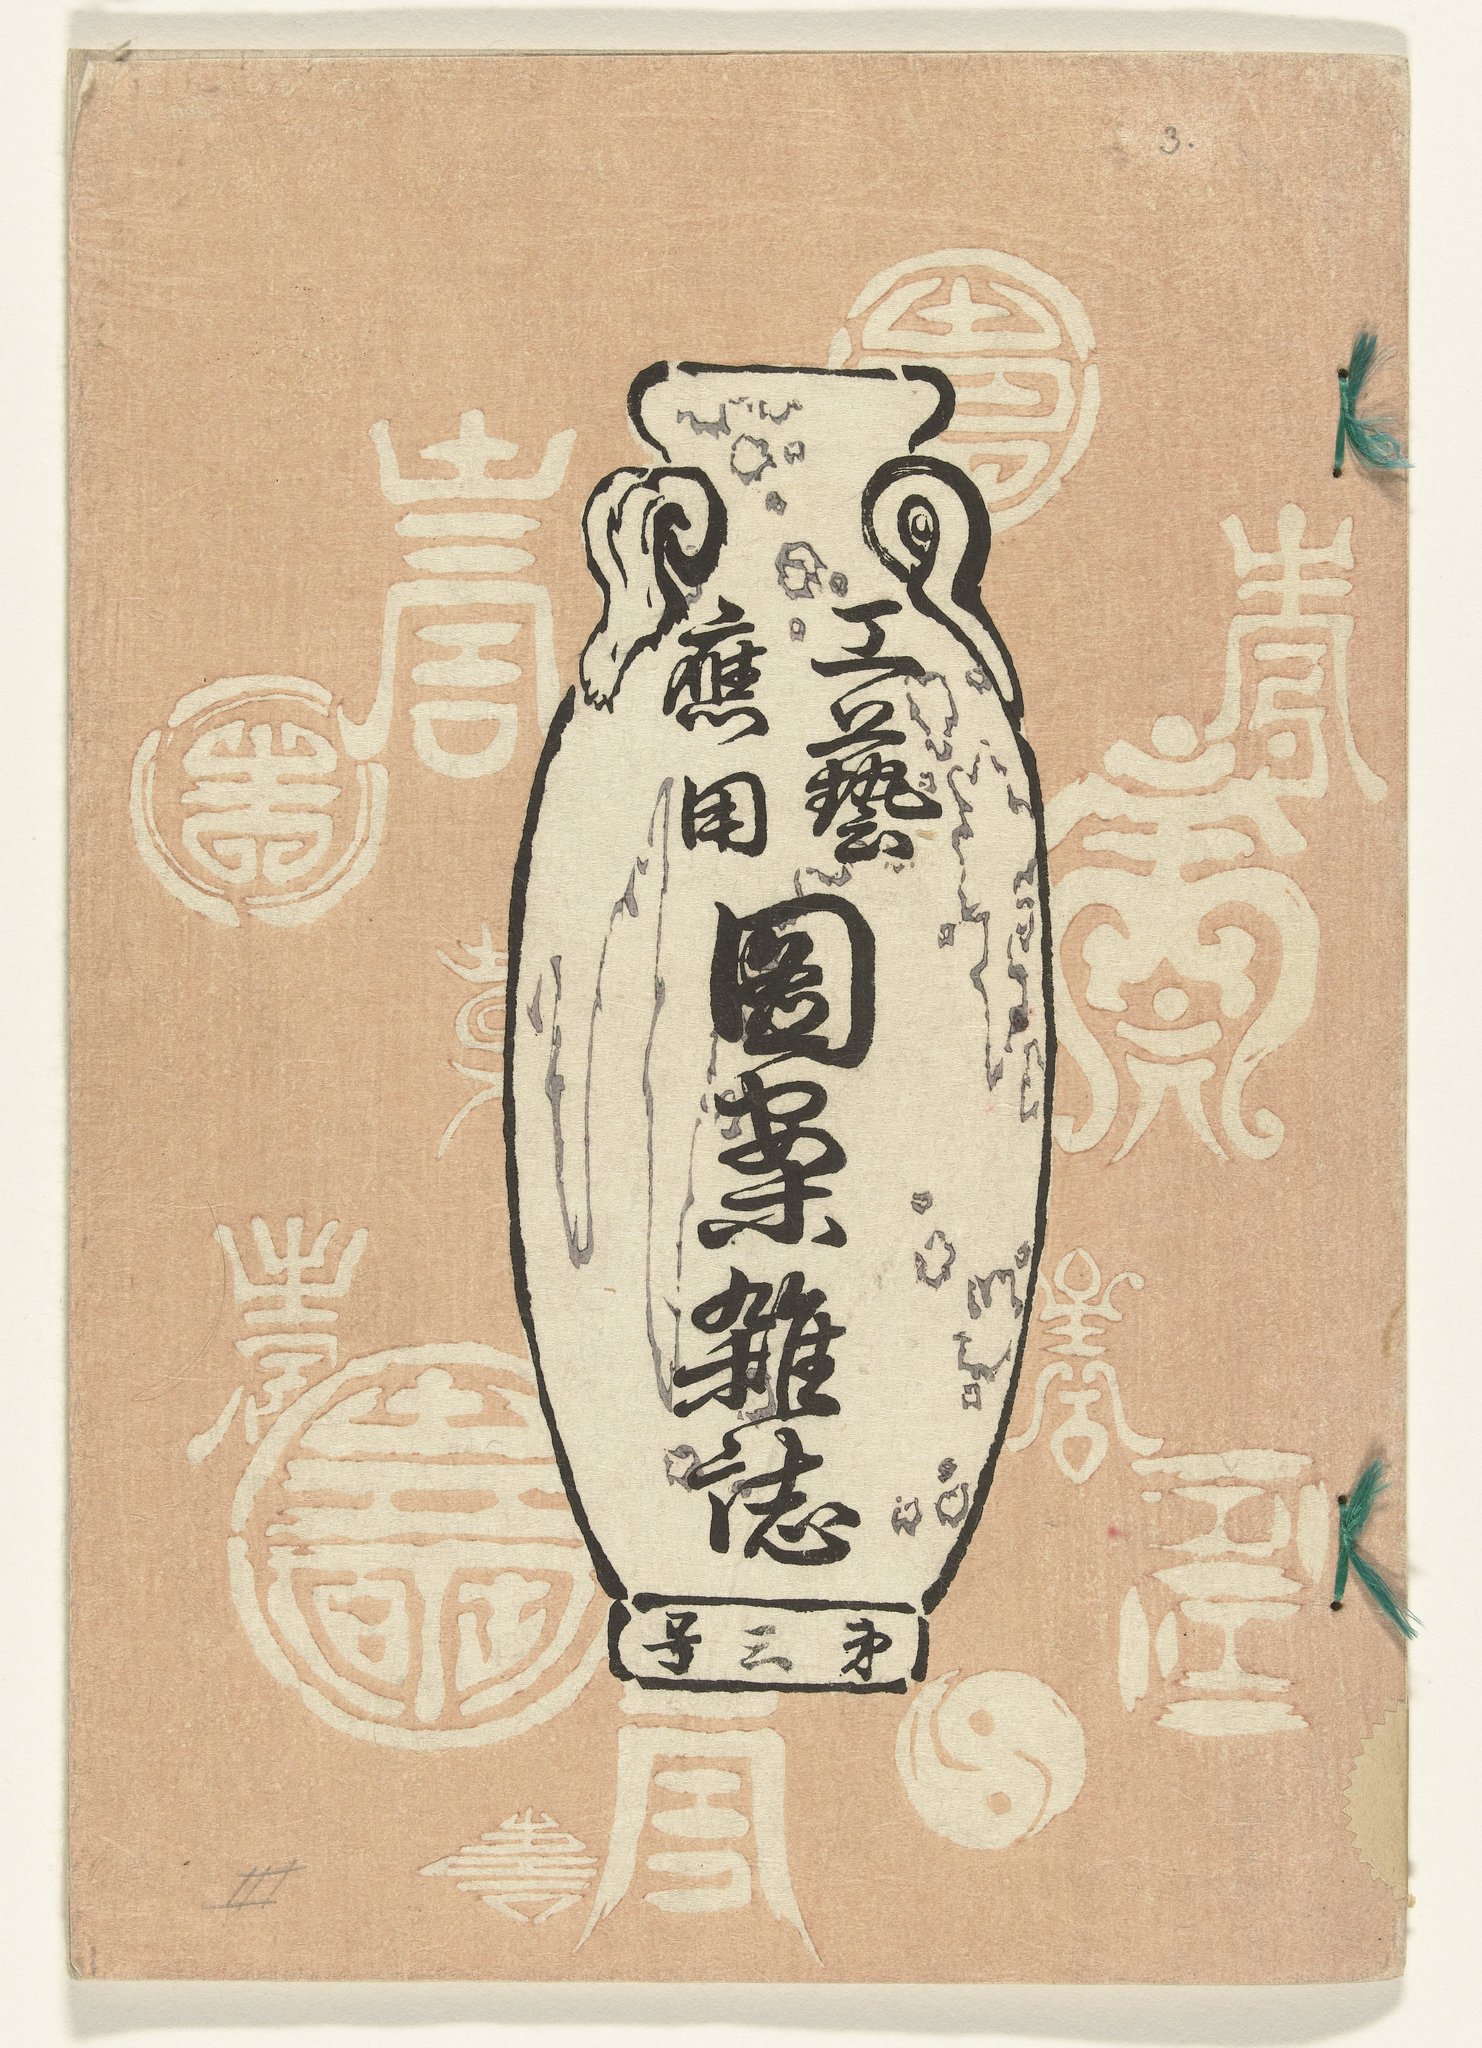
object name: book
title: Ontwerpen voor toegepaste kunst- deel drie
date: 1890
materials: paper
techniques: woodcut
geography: tokyo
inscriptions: collector's mark: ‘Rijksschool voor kunstnijverheid’ Lugt 3937